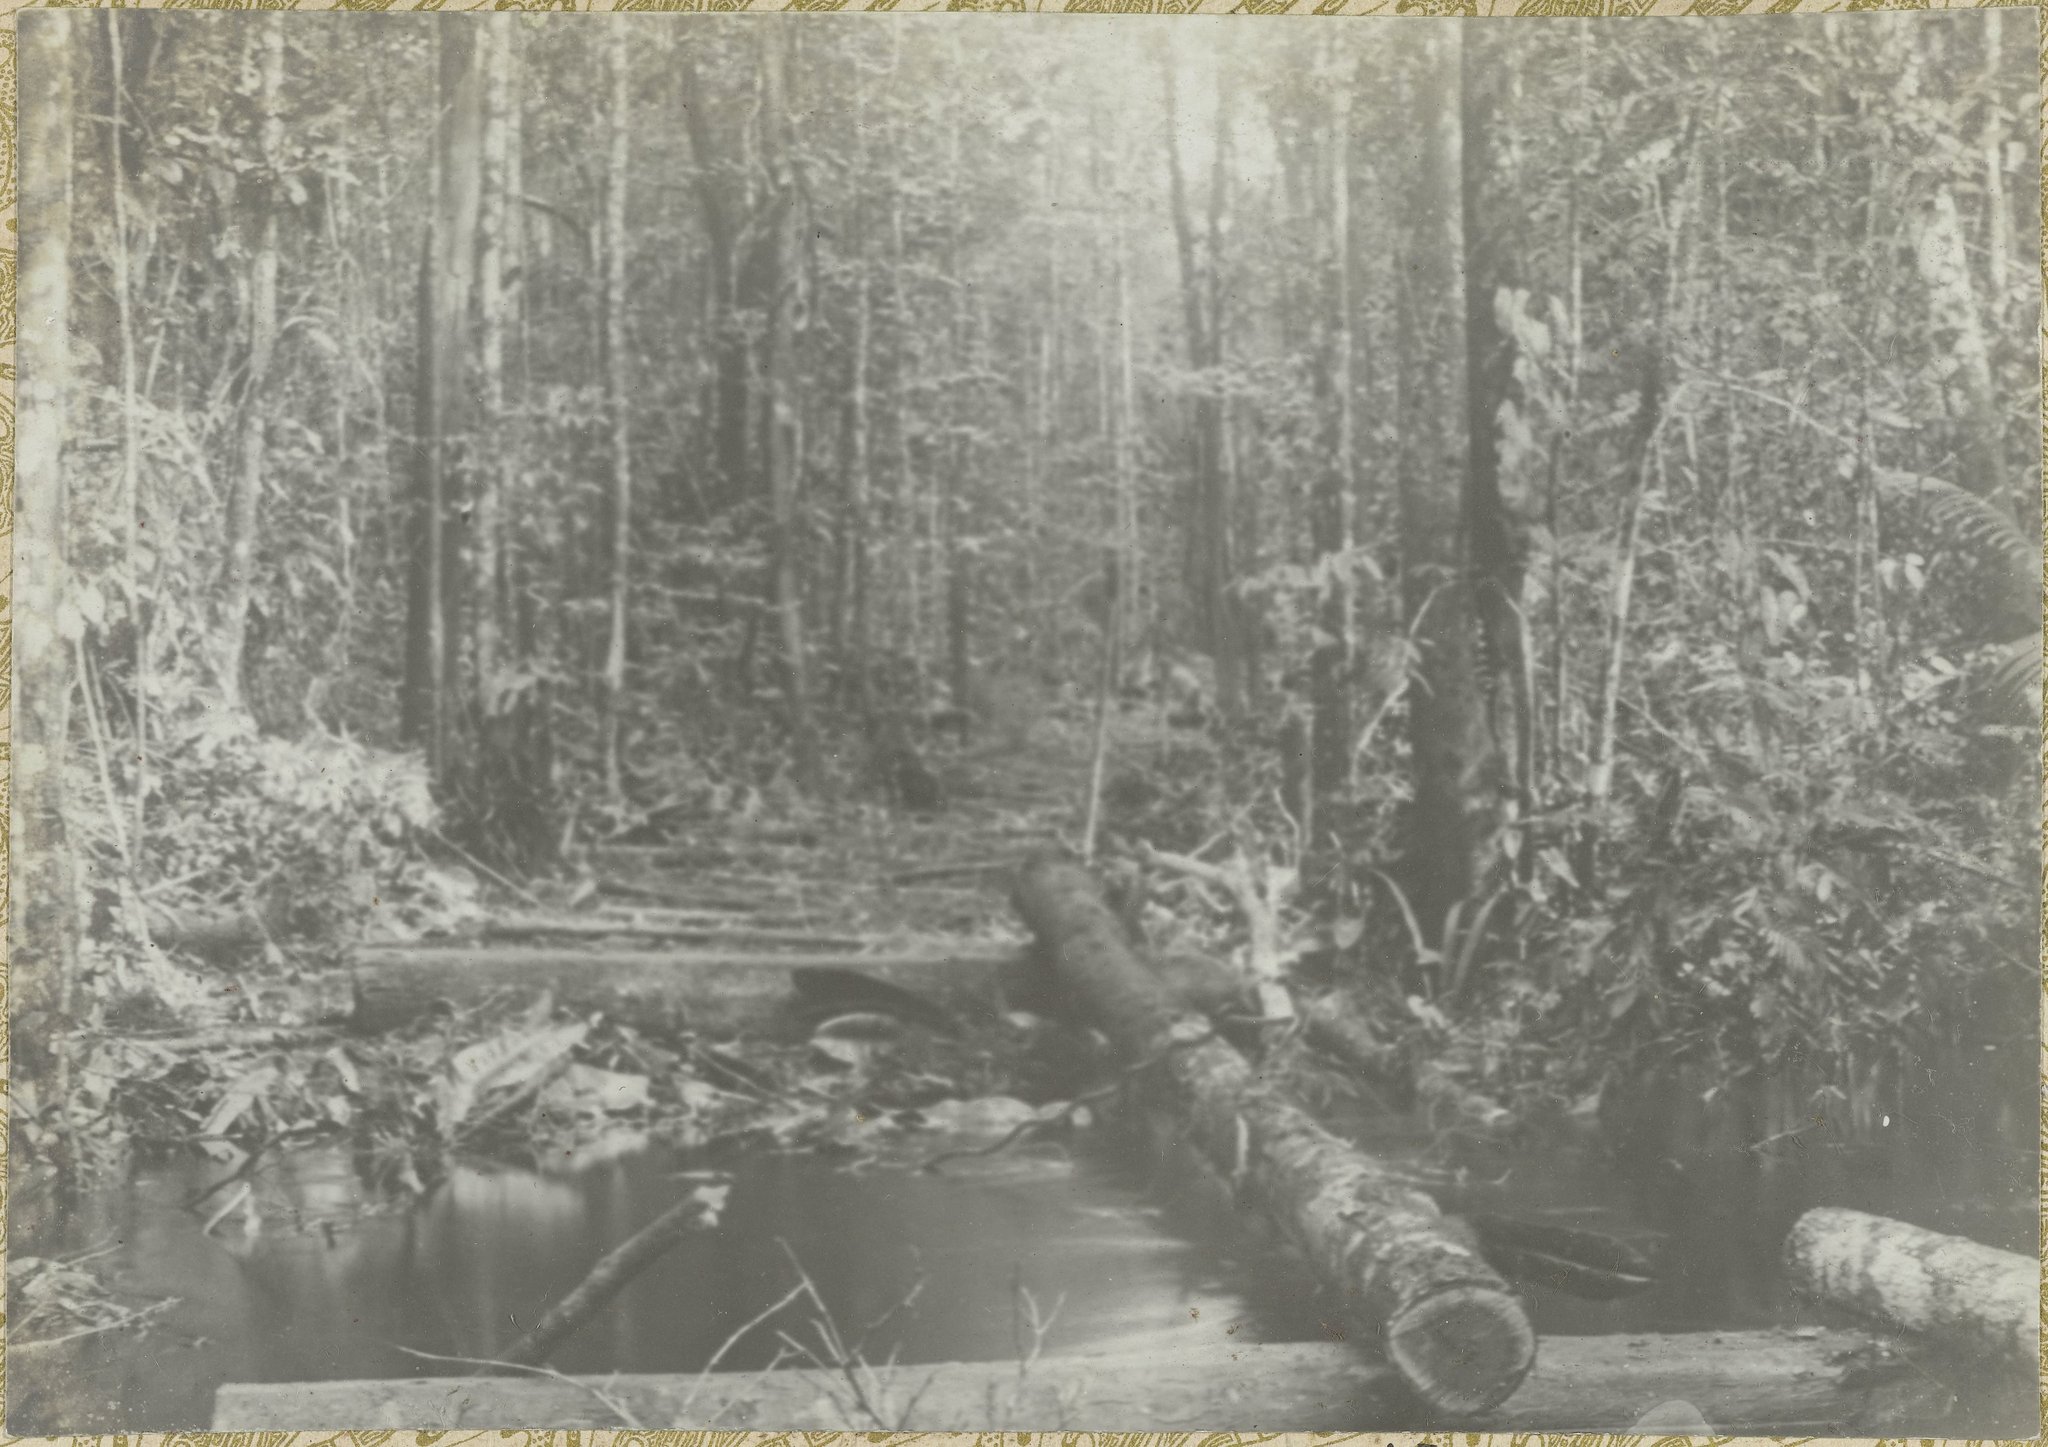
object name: photograph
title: Gezicht in het bos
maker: hendrik doijer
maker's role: engineer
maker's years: 1863-1925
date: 1903-1910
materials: photographic support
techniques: gelatin silver print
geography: suriname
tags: suriname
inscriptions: inscription: ‘Vergrooting van’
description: Gezicht in het bos met enkele gekapte boomstammen. Onderdeel van het fotoalbum Souvenir de Voyage (deel 1), over het leven van de familie Doijer in en rond de plantage Ma Retraite in Suriname in de jaren 1903-1910.